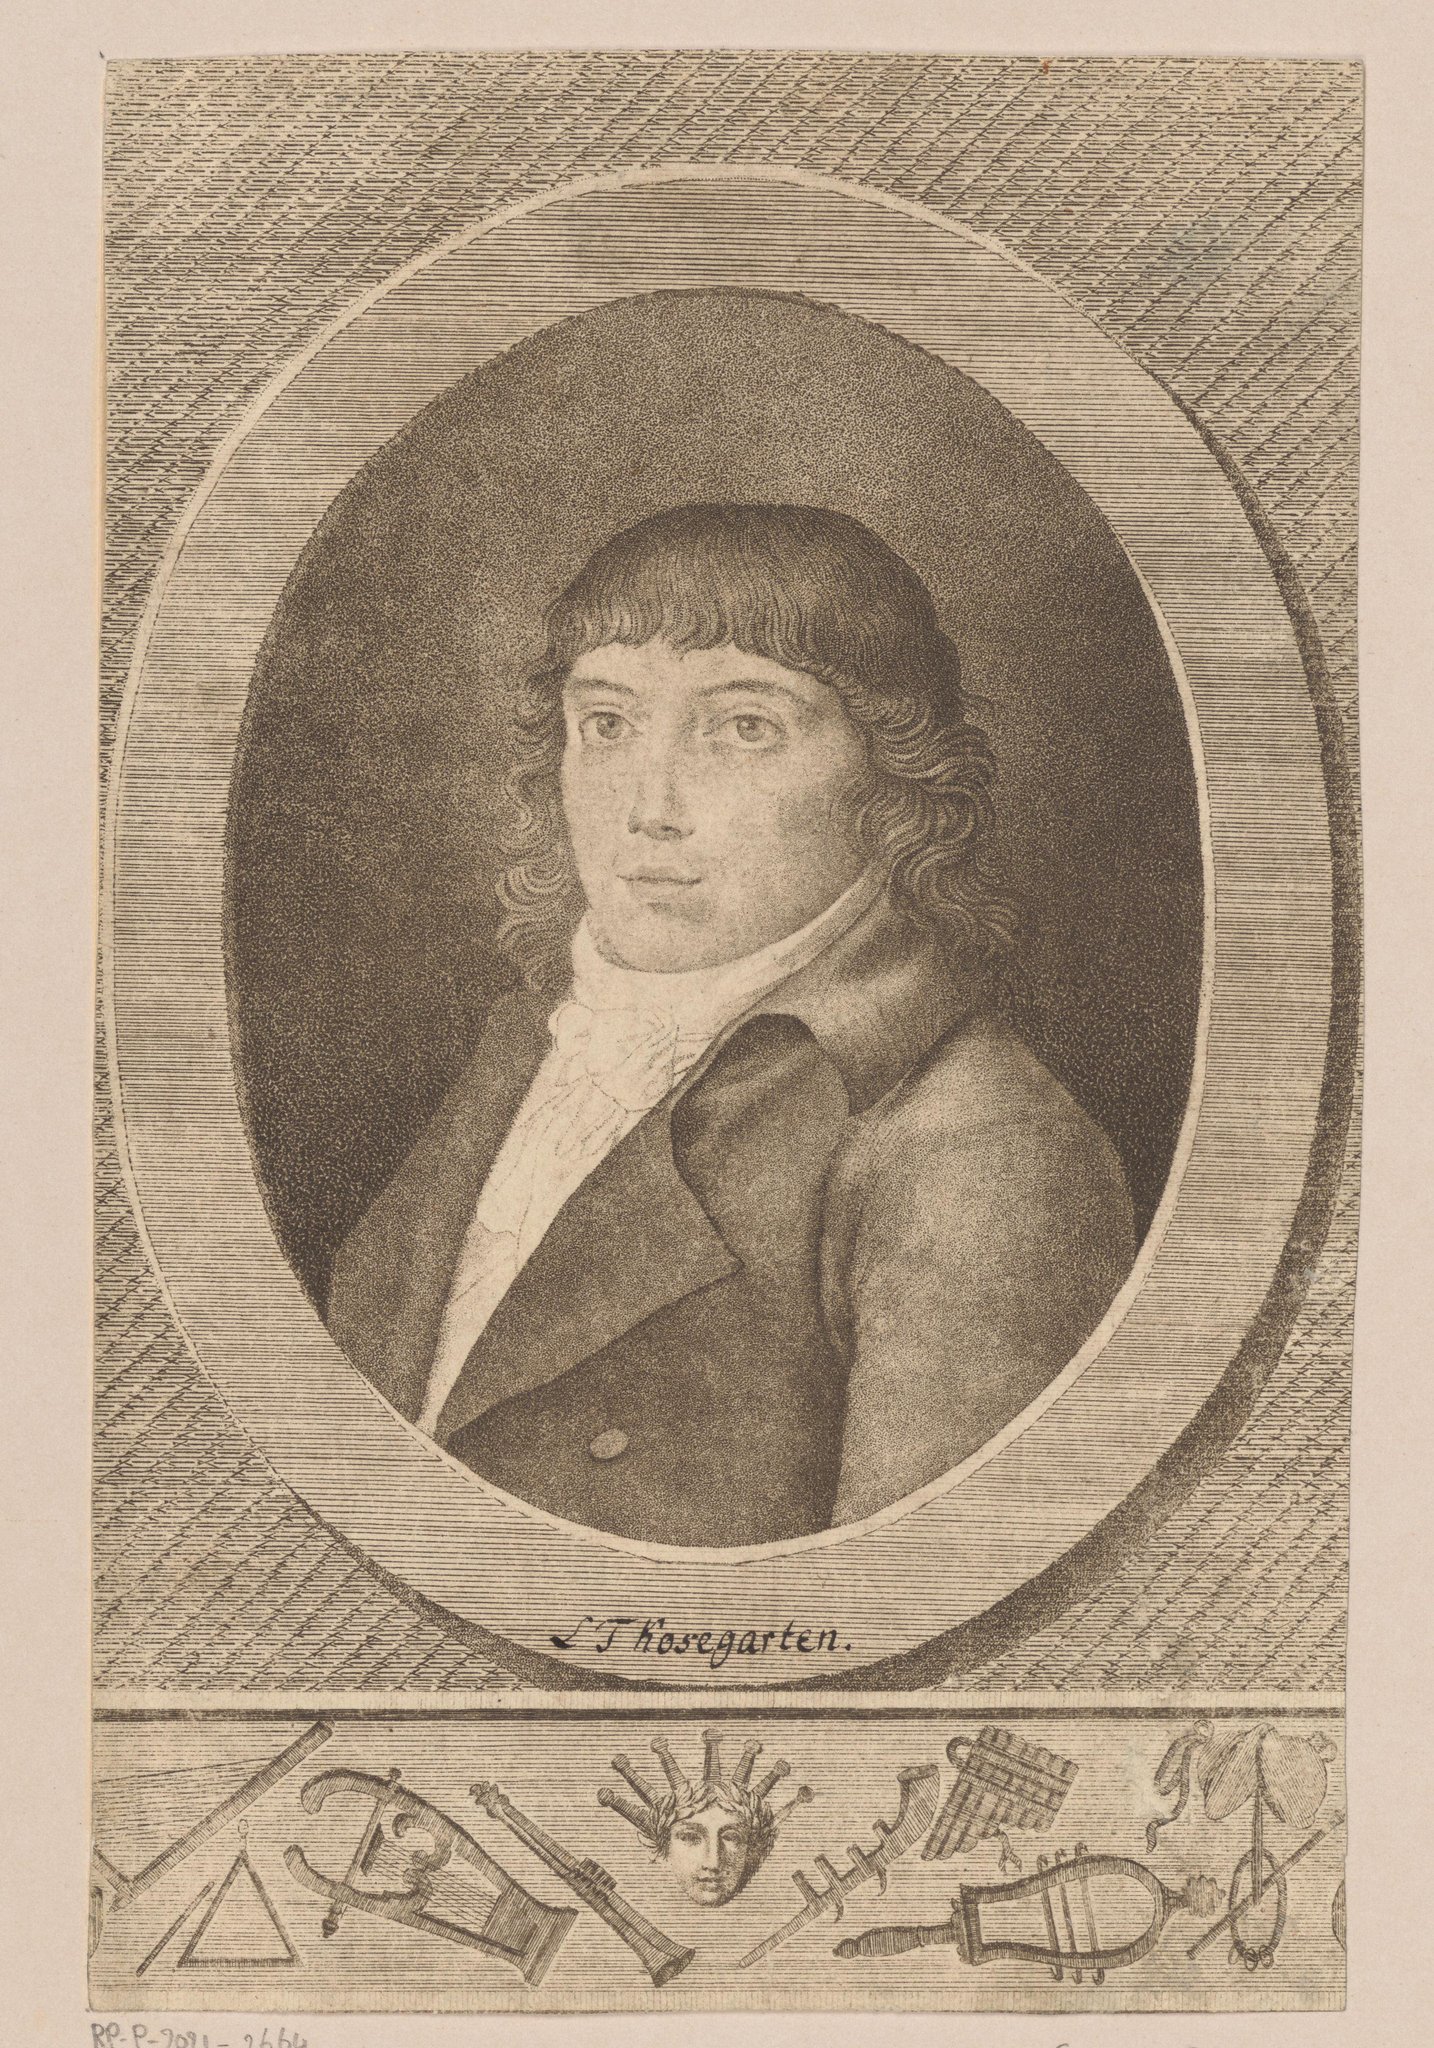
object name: print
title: Portret van Ludwig Gotthard Kosegarten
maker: Anonymous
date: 1768-1849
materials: paper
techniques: etching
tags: musical instruments; group of musical instruments, historical persons